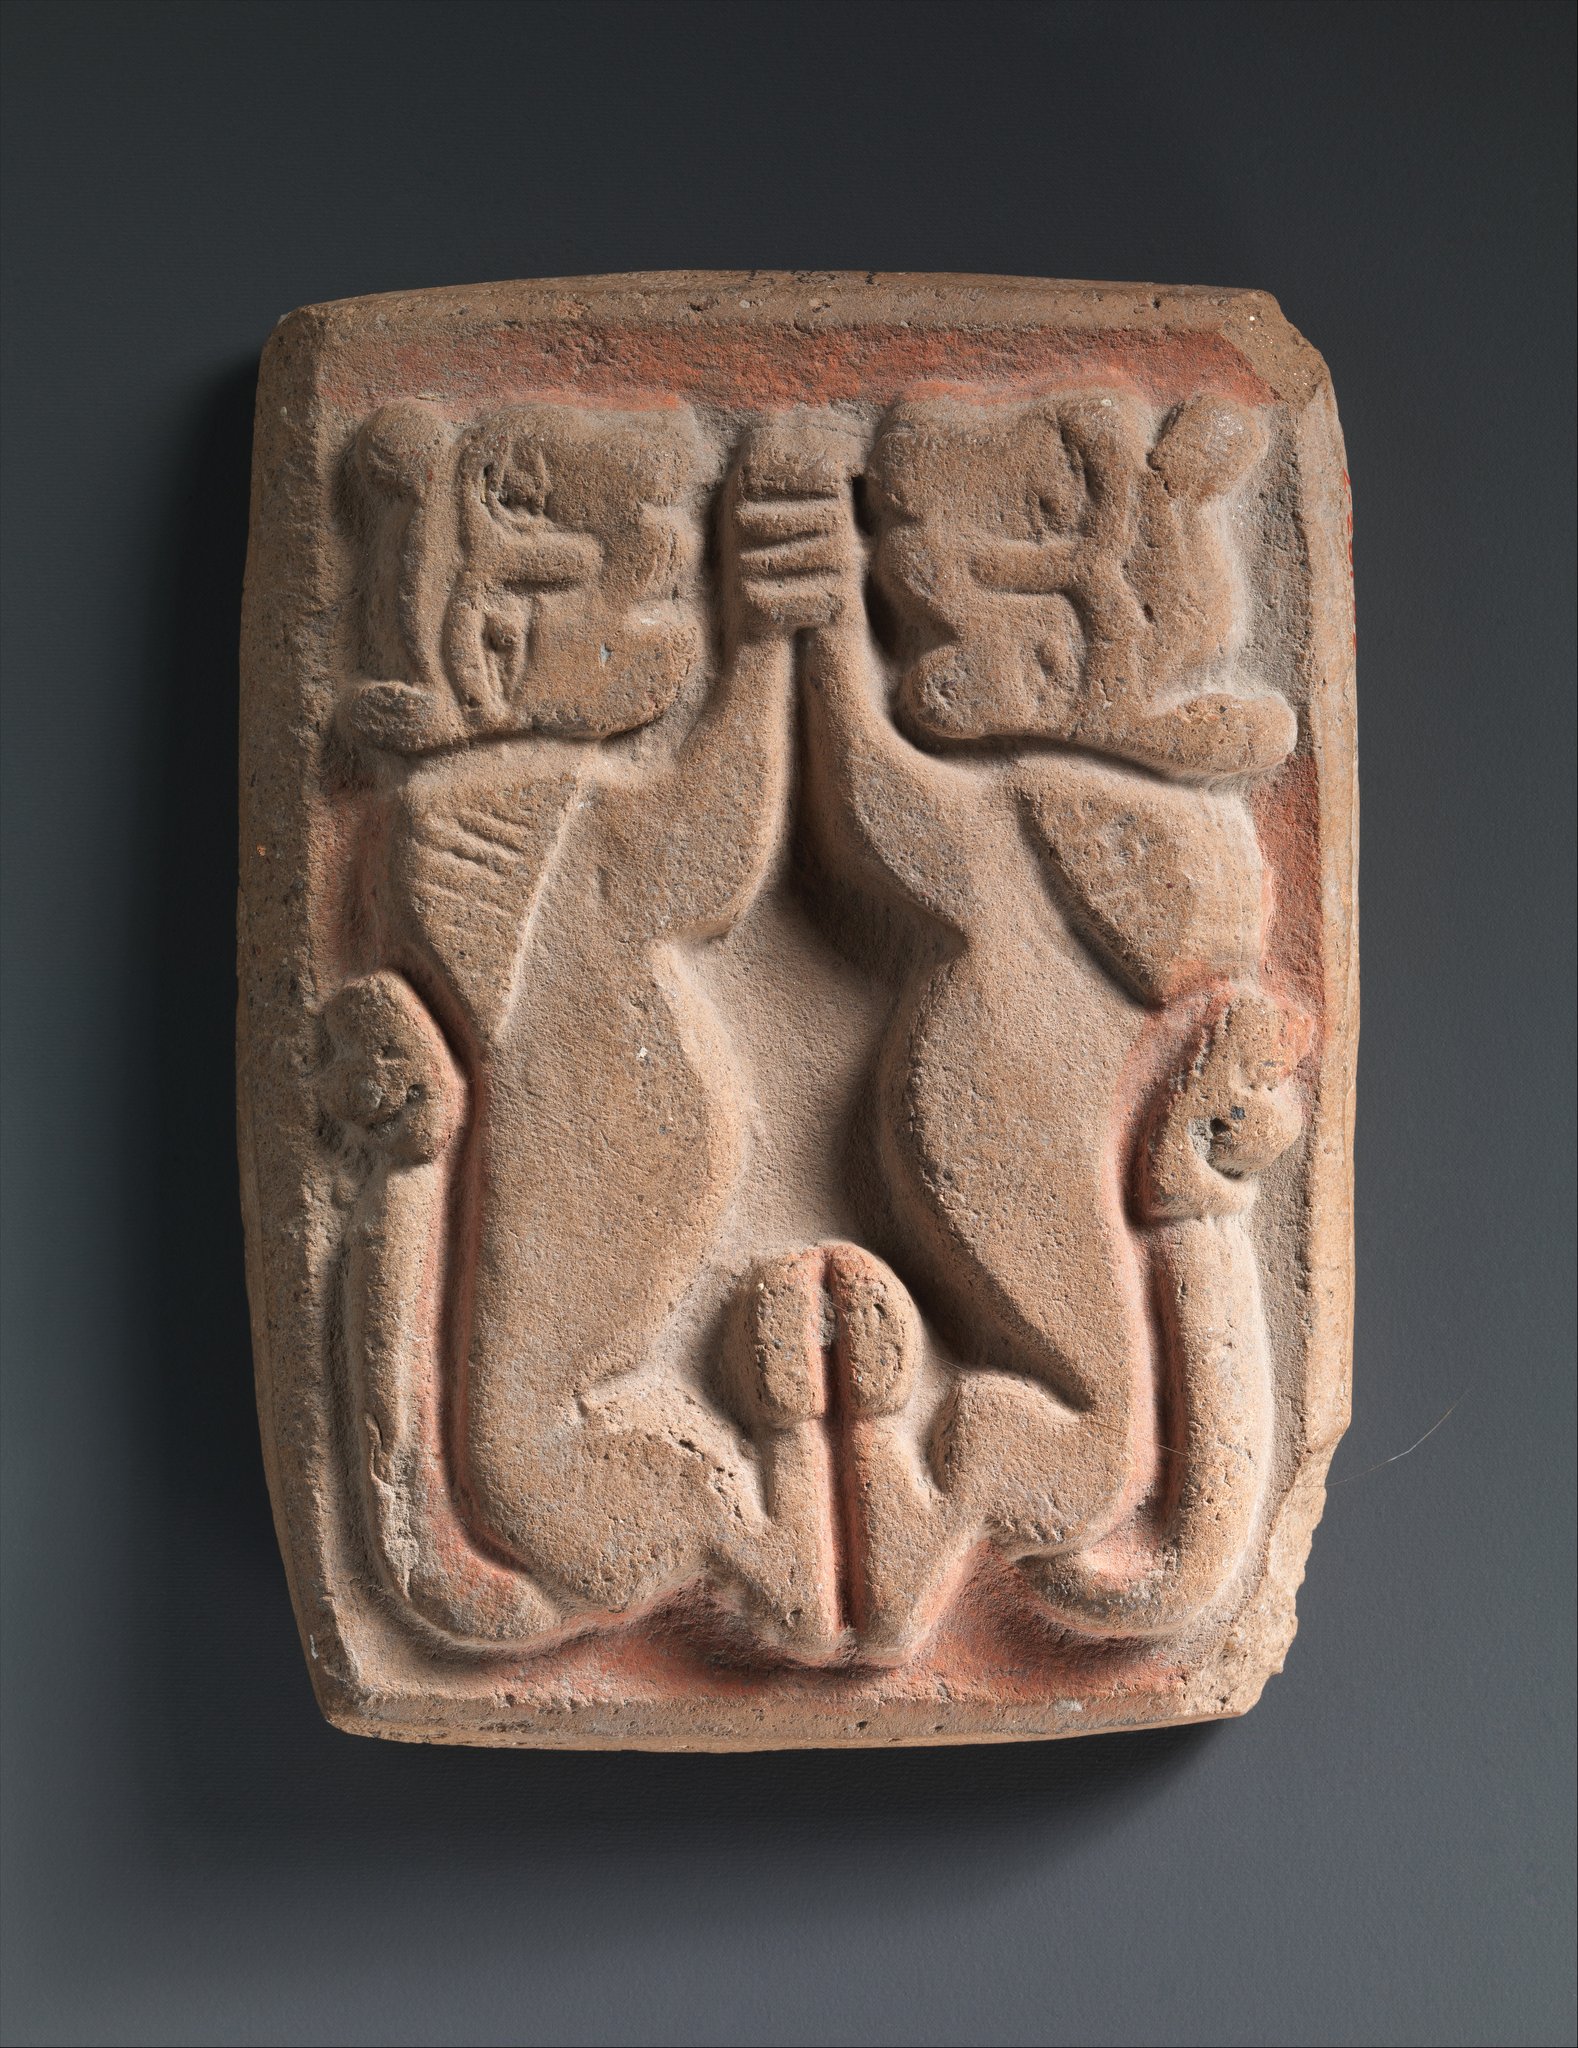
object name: bath scraper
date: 1101-1300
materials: earthenware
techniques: molding, relief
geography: iran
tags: lions